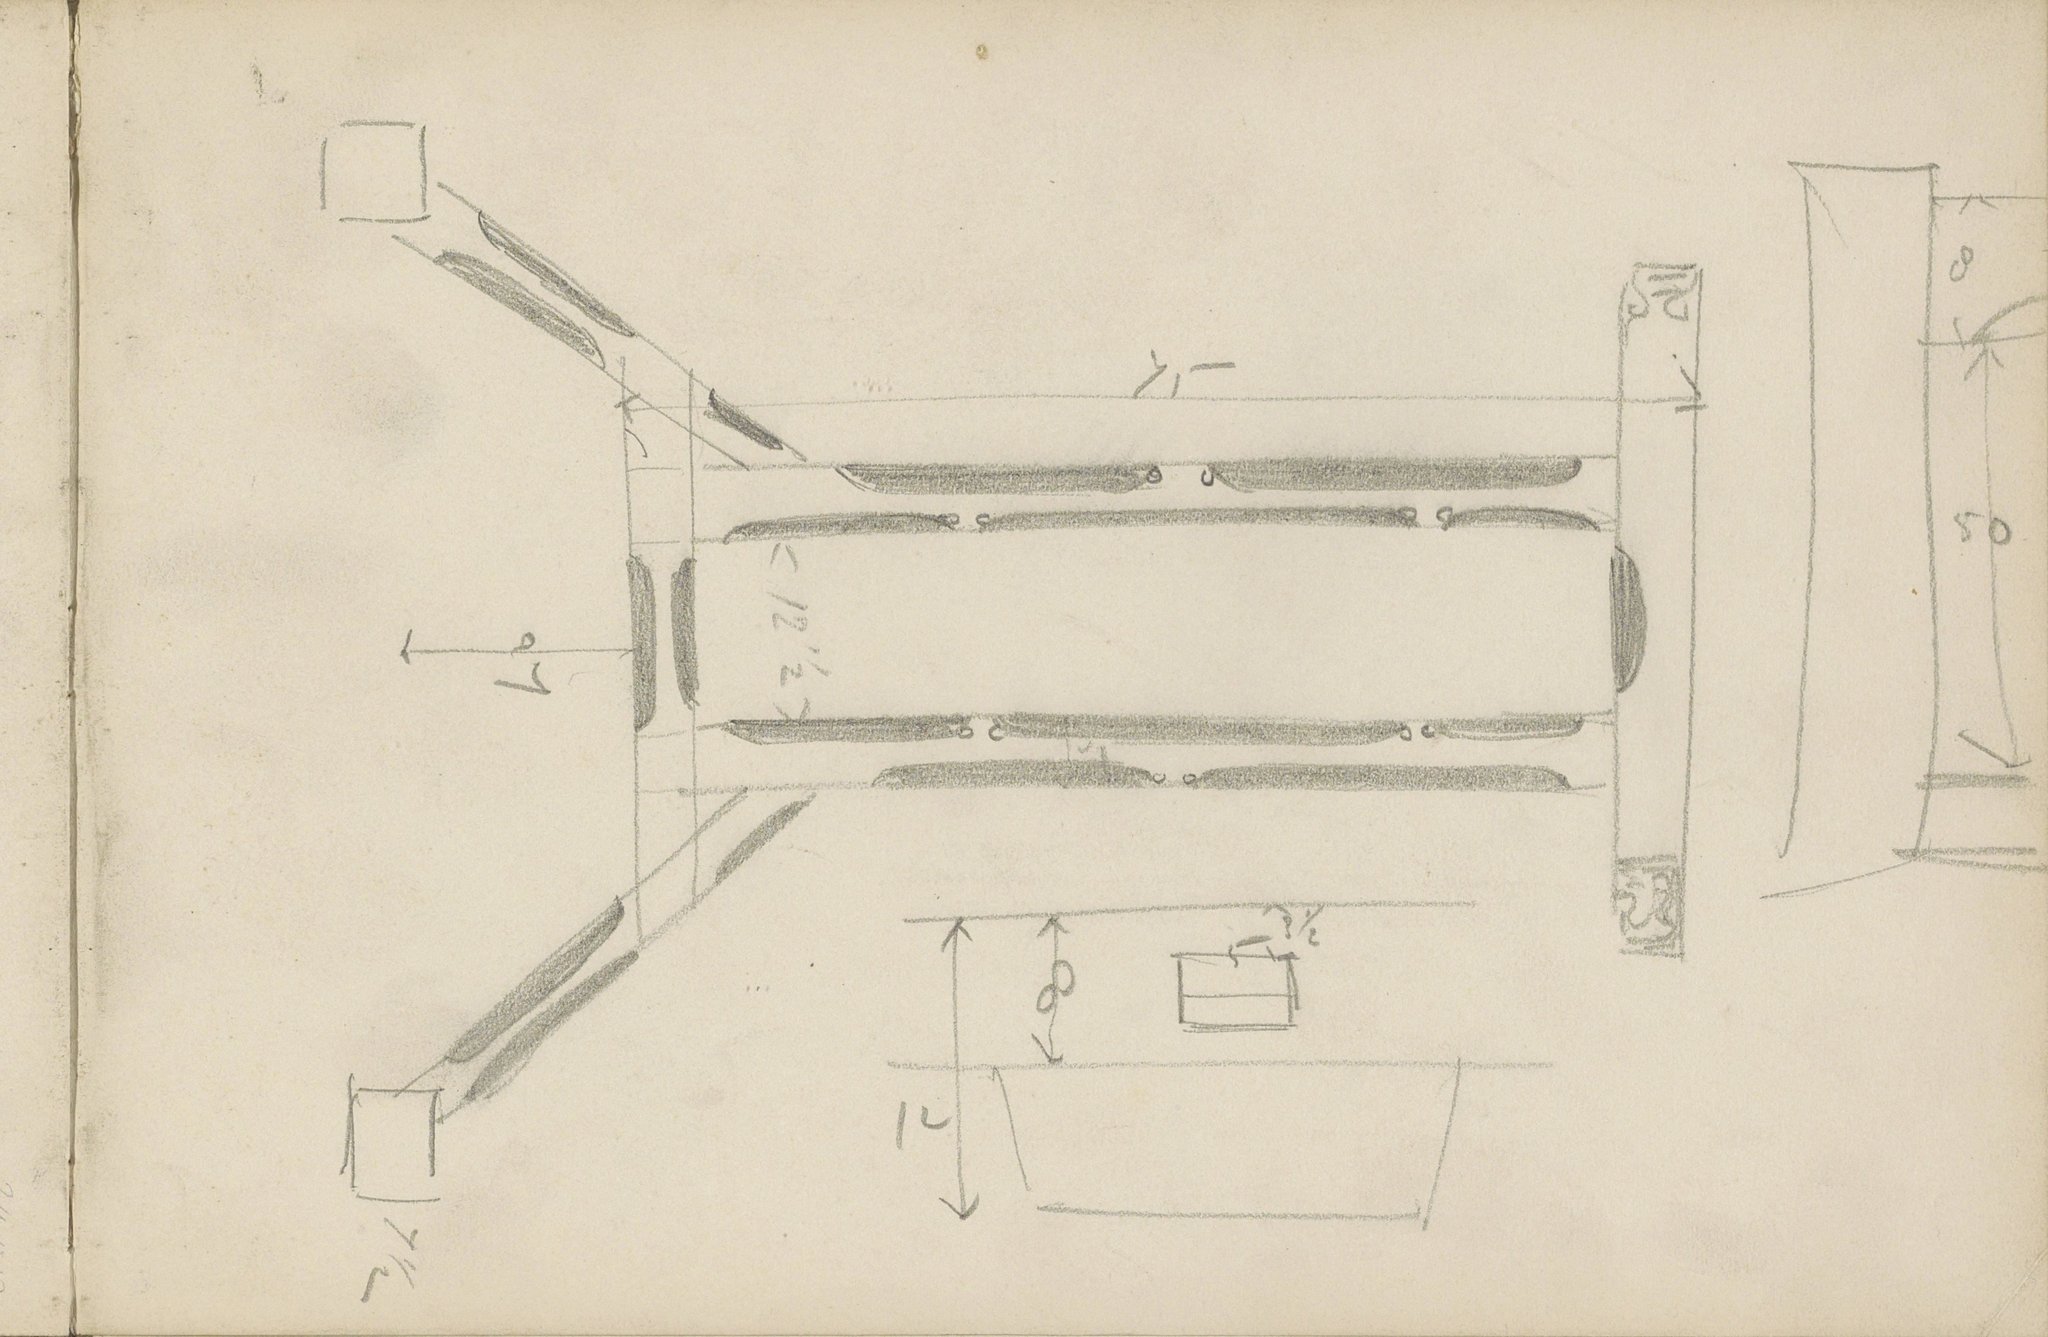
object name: sketchbook leaf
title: Ontwerp voor een meubel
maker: carel adolph lion cachet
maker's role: draughtsman, print maker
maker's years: 1864-1945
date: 1908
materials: paper, pencil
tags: furniture and household effects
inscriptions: annotation: ‘[...]’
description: Mogelijk een ontwerp voor een tafel. Blad 18 recto uit een schetsboek met 25 bladen.